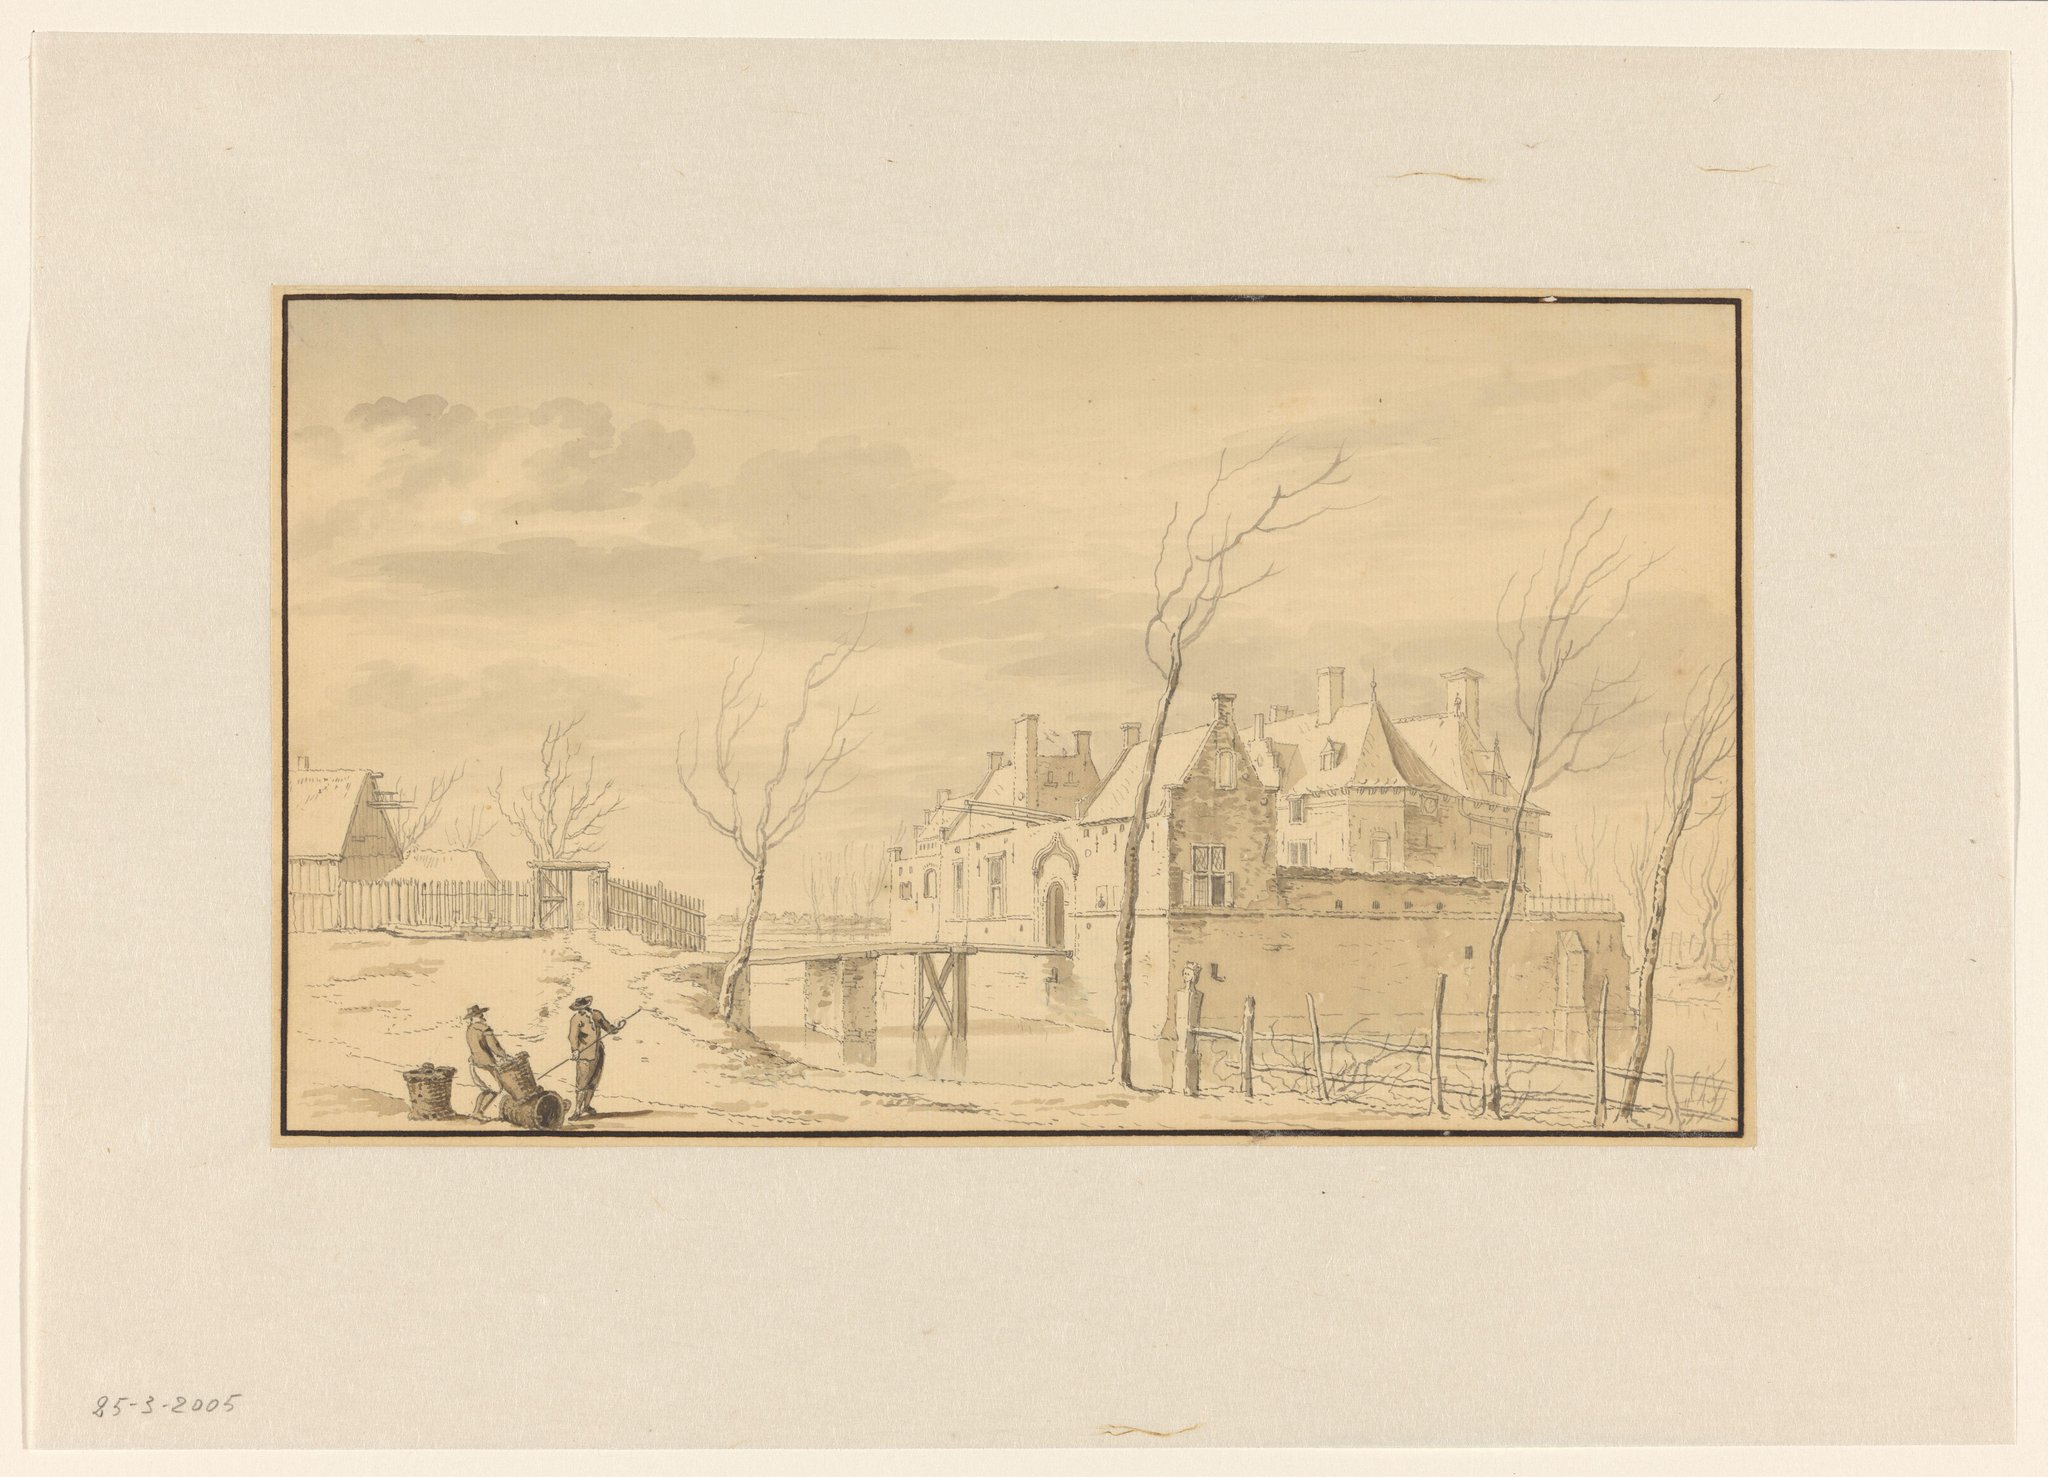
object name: drawing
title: Het huis Bakelaar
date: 1686-1735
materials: ink, paper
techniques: brush, pen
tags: castle